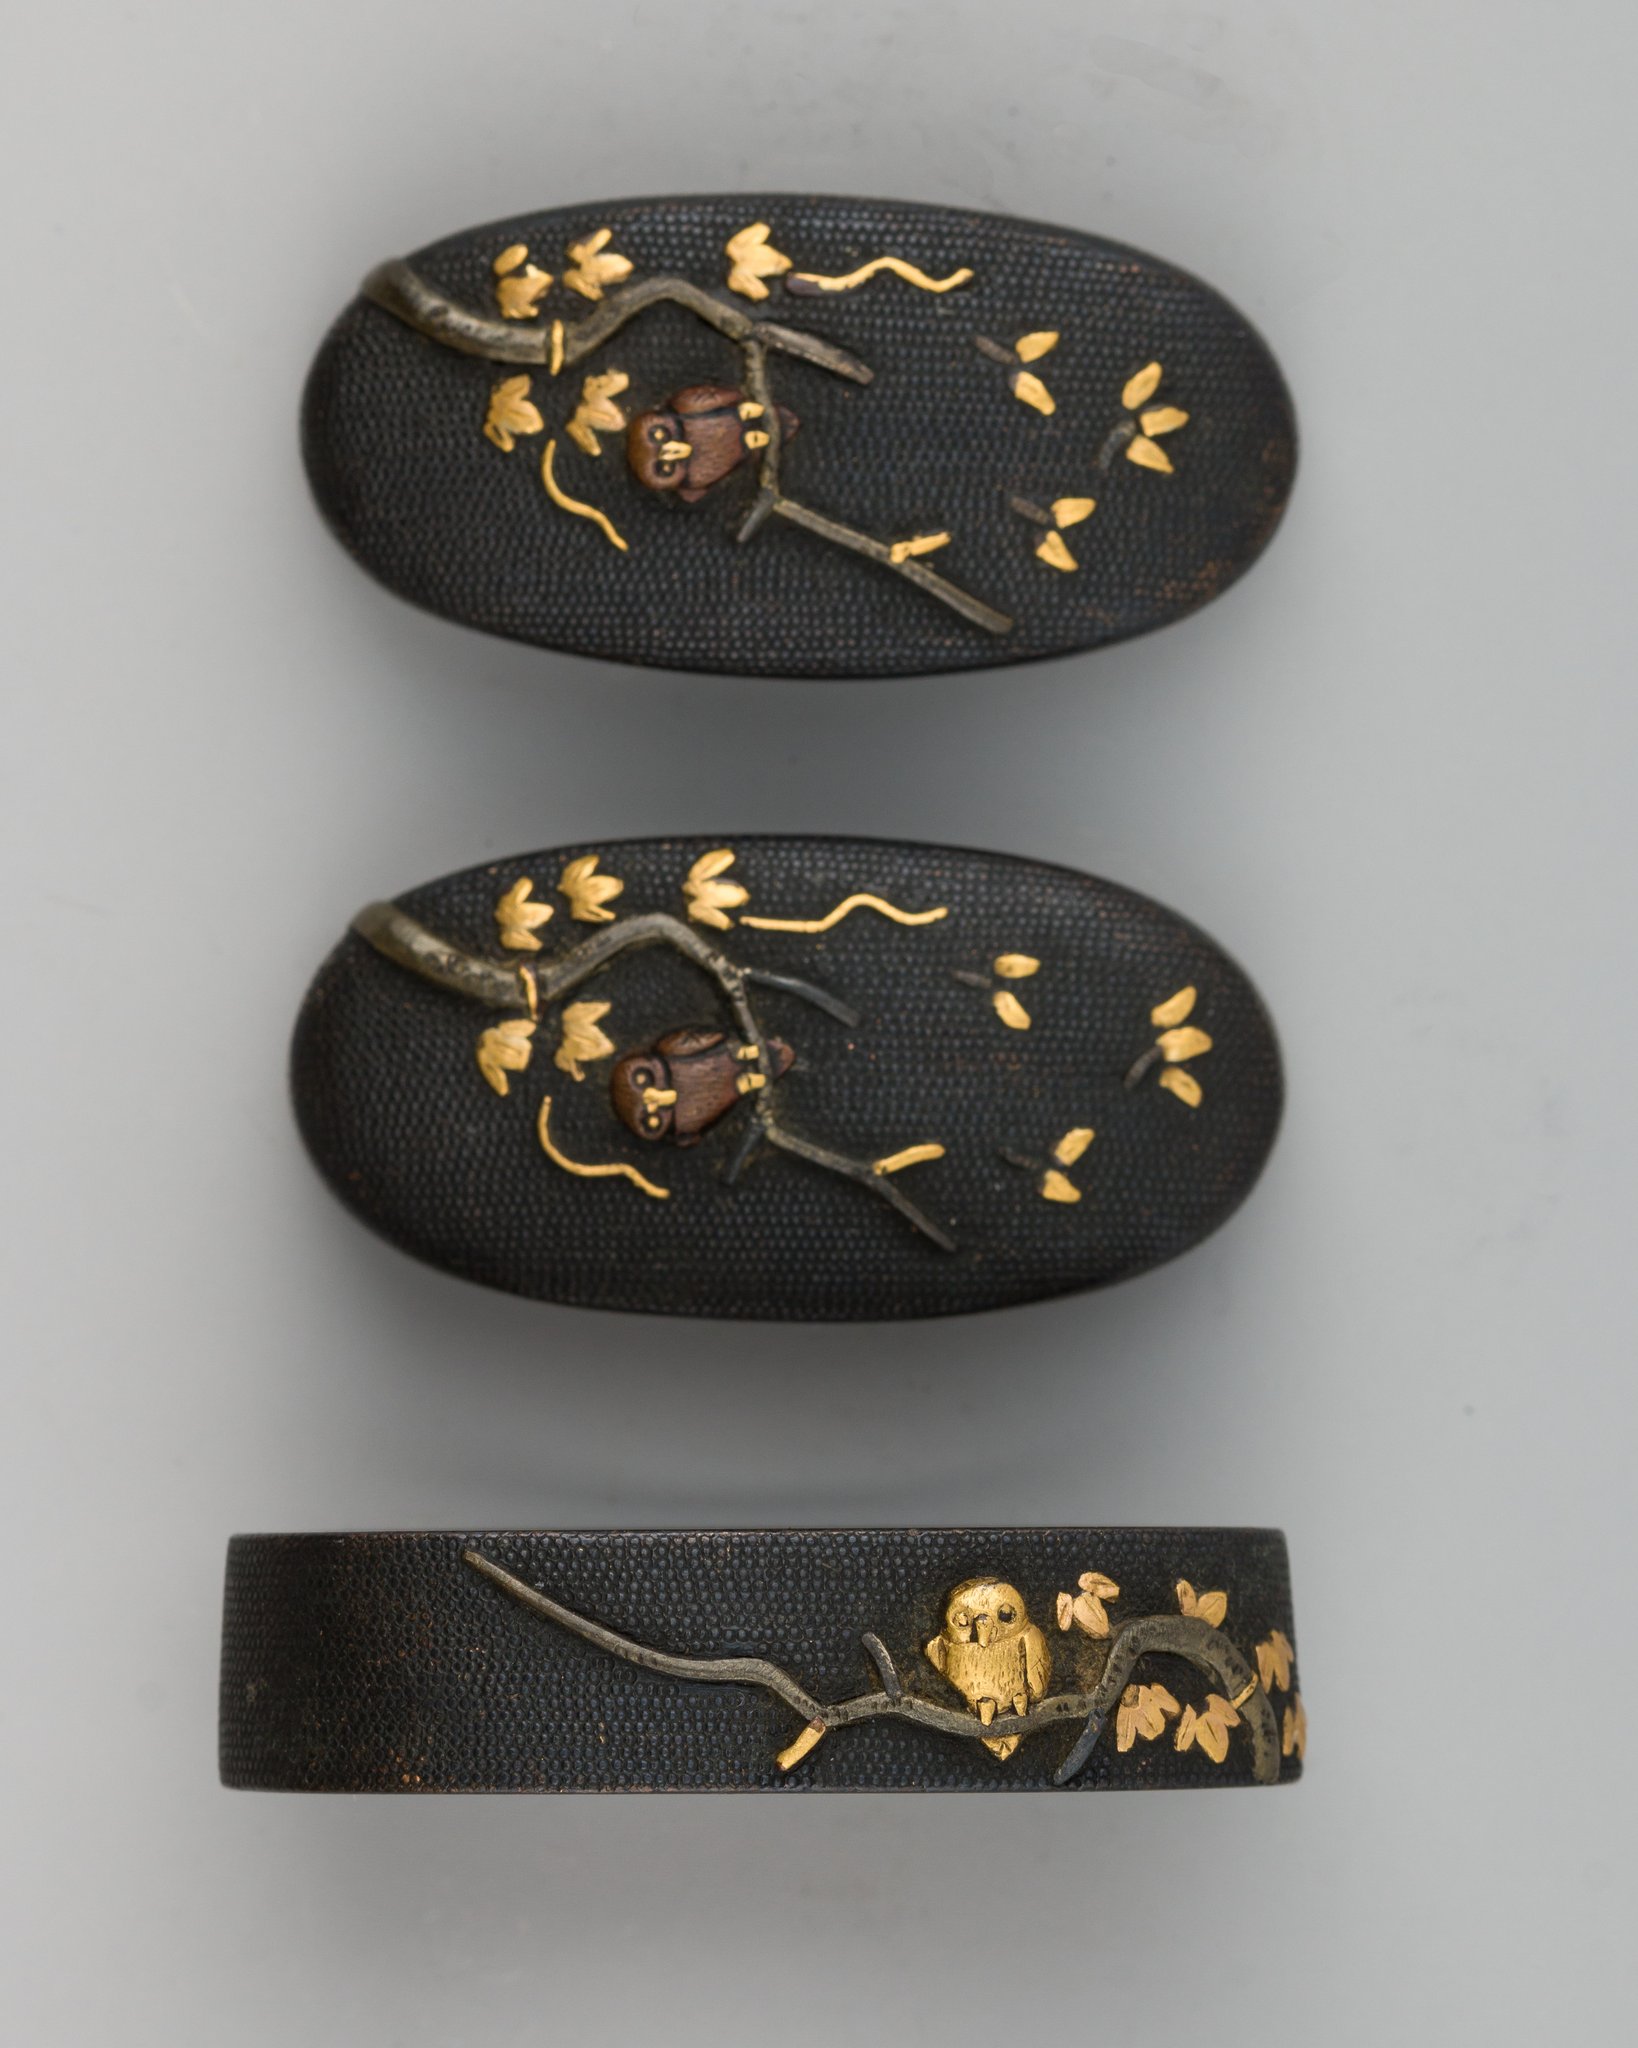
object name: sword hilt collar and pommel fuchigashira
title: Sword-Hilt Collar and Two Pommels (Fuchigashira)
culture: japanese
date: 1615-1868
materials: copper, gold alloy, silver alloy, gold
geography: japan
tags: birds,leaves